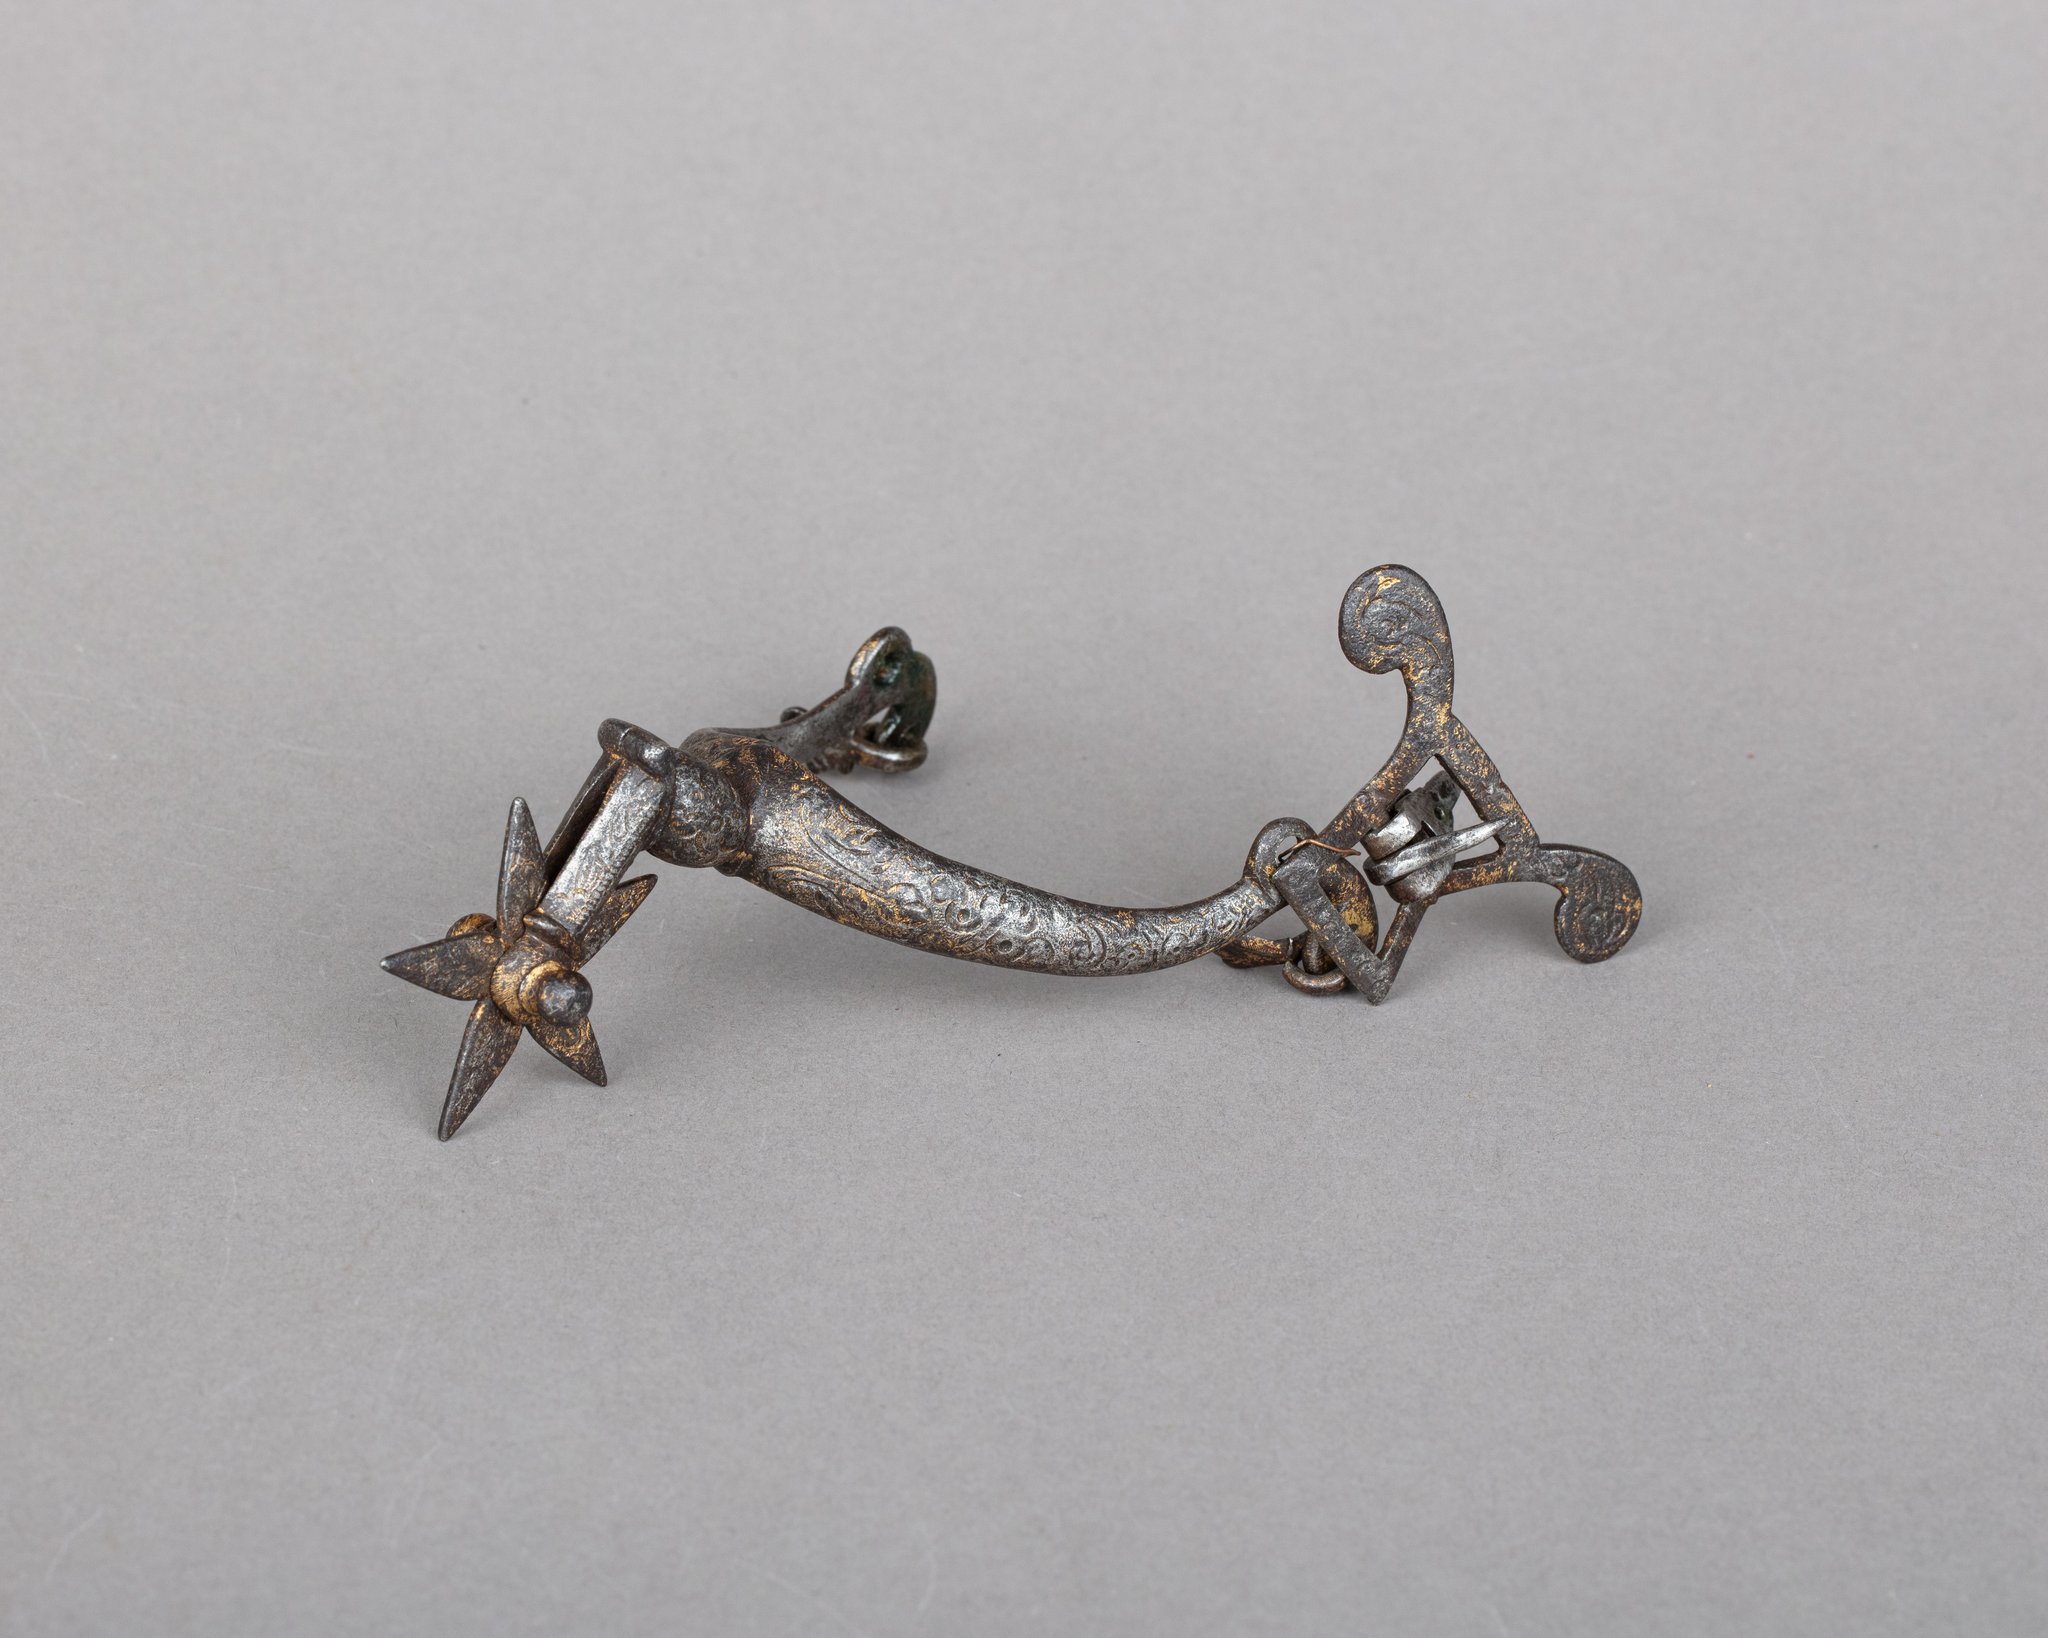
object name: spur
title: Rowel Spur (Right)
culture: german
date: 1630-1660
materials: gold, iron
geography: germany